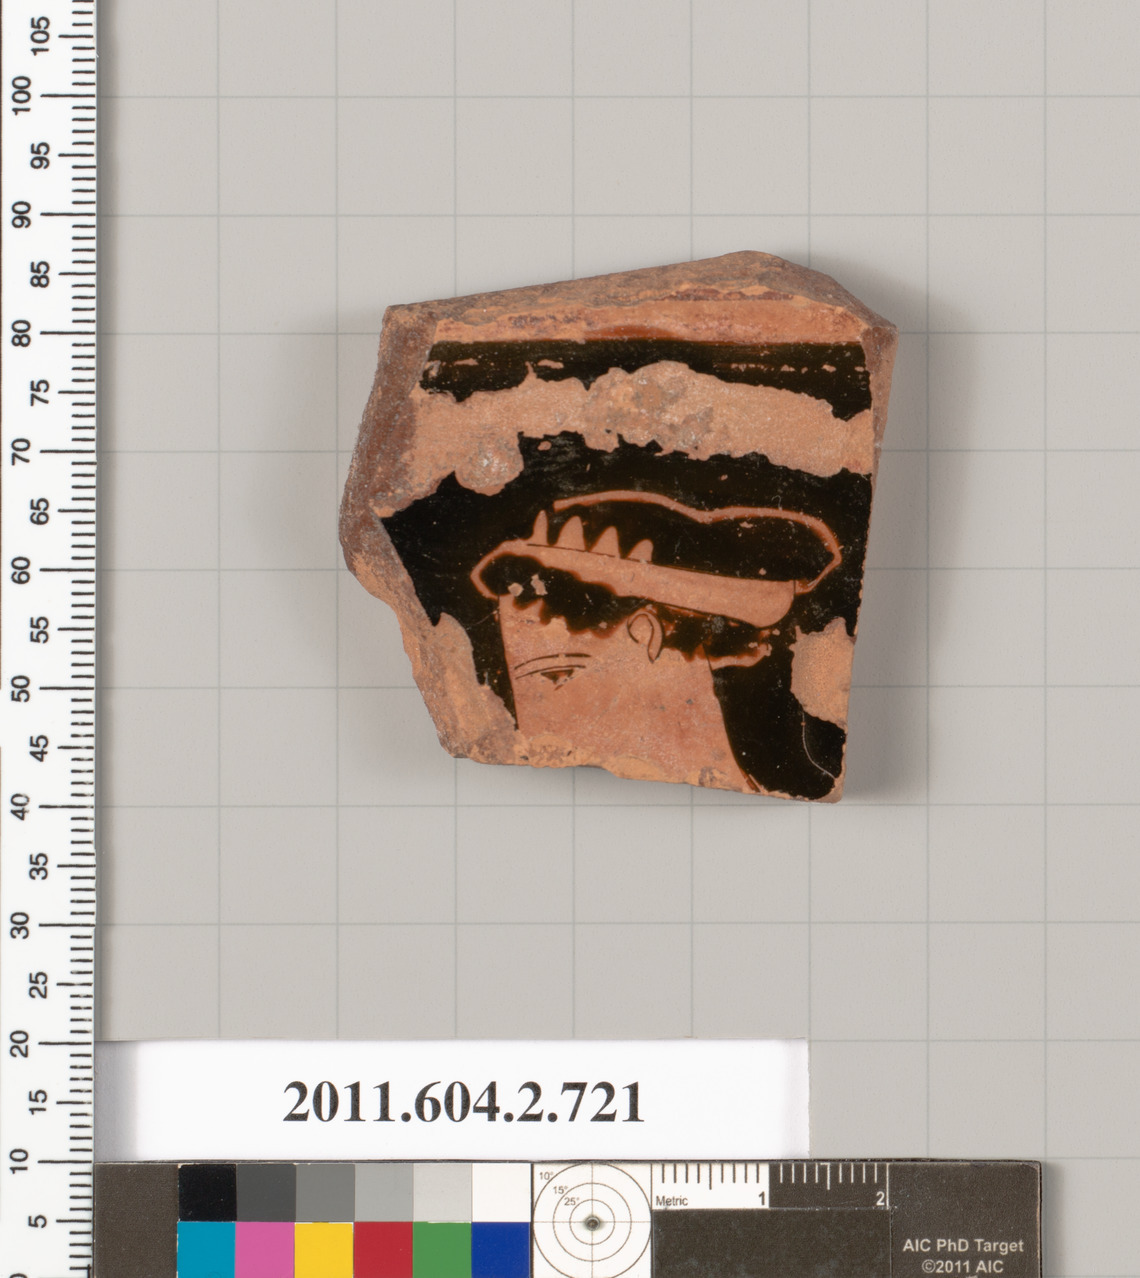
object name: calyx krater fragment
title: Terracotta fragment of a calyx-krater (bowl for mixing wine and water)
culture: greek, attic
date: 440-430 BCE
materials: terracotta